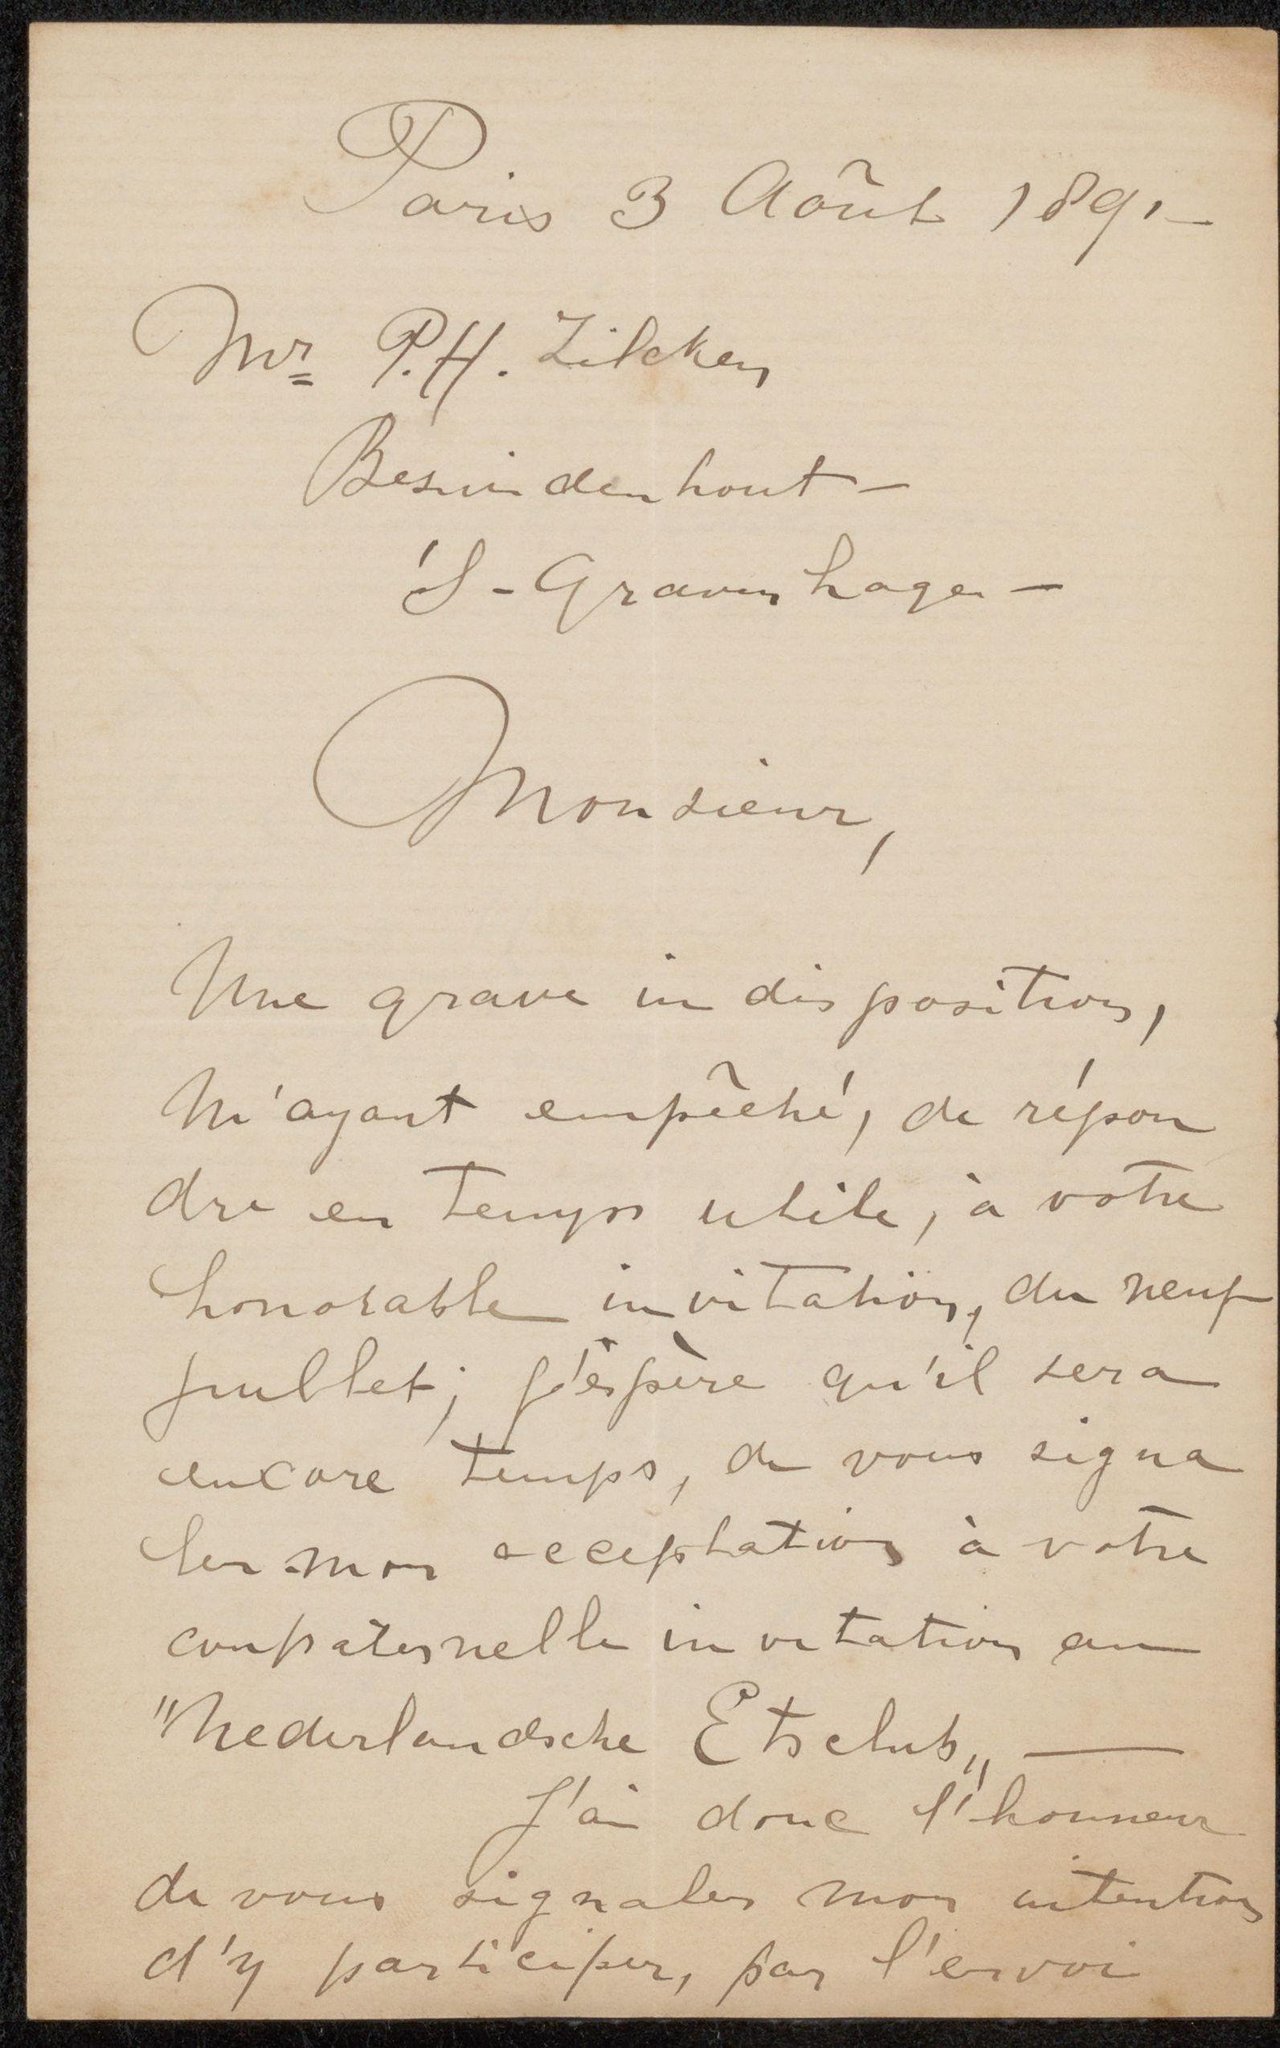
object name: letter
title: Brief aan Philip Zilcken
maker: marcellin gilbert desboutin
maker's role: print maker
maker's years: 1823-1902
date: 1891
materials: ink, paper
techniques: pen, writing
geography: paris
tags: the hague, painter, draughtsman, philip zilcken, the graphic arts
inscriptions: collector's mark: ‘RPK’